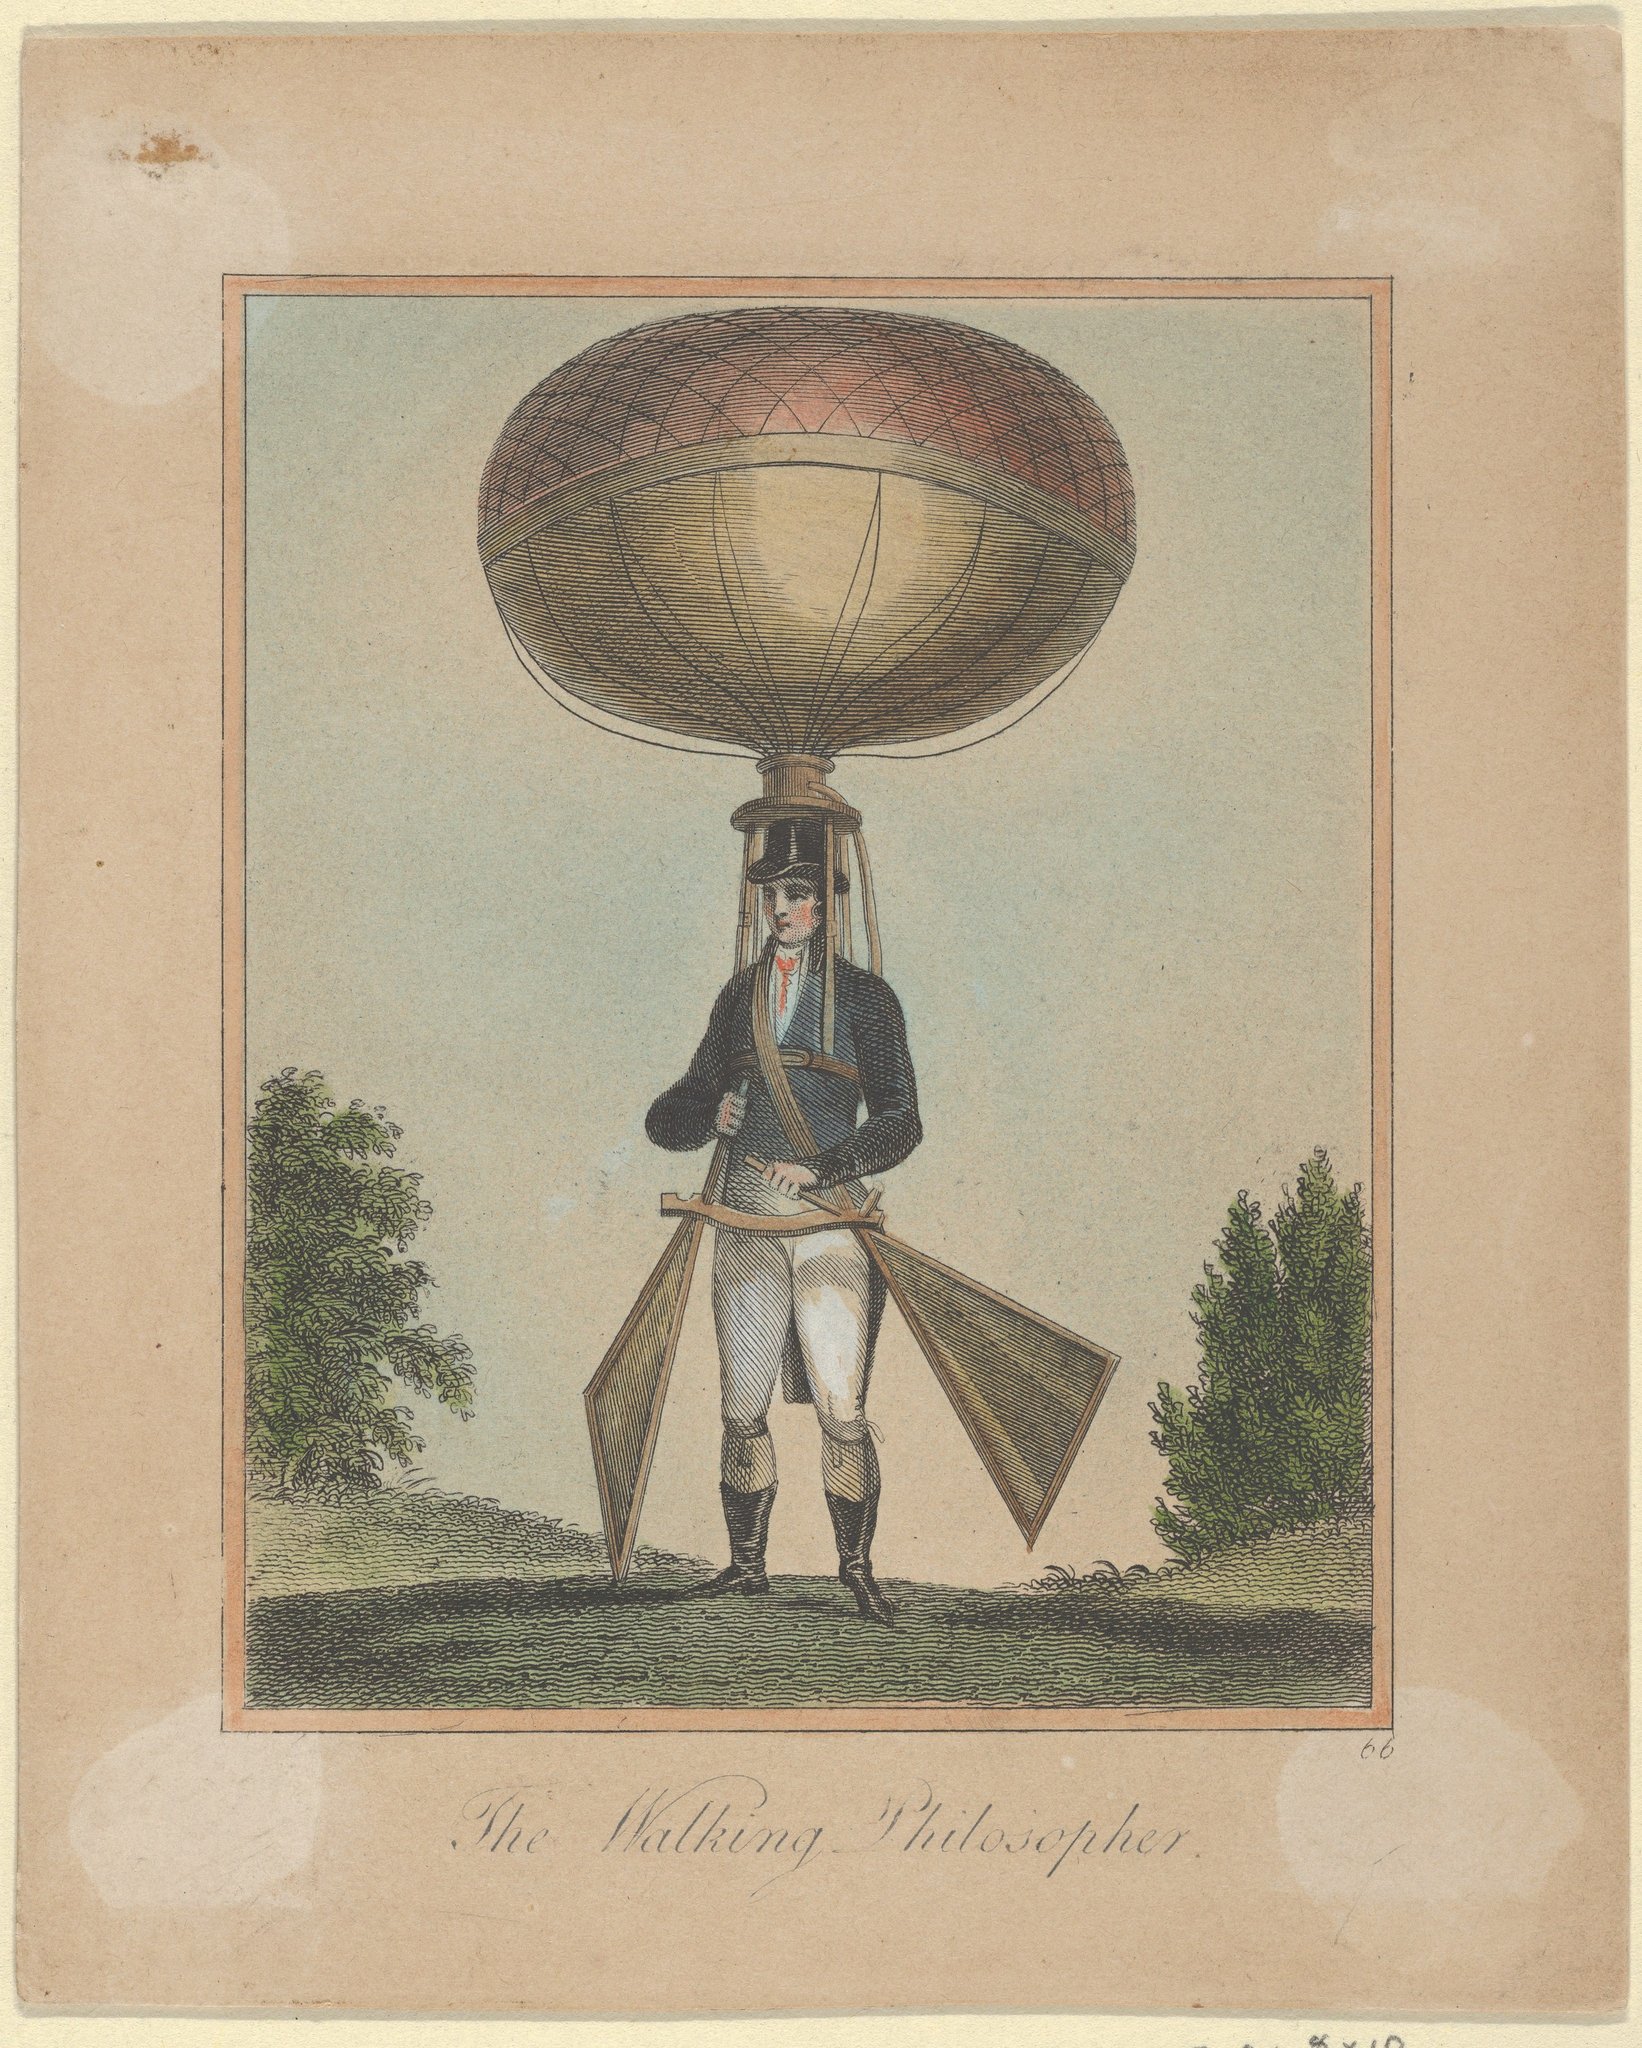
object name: print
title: The Walking Philosopher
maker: Anonymous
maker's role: artist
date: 1800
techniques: etching, hand coloring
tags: men,walking,philosophers